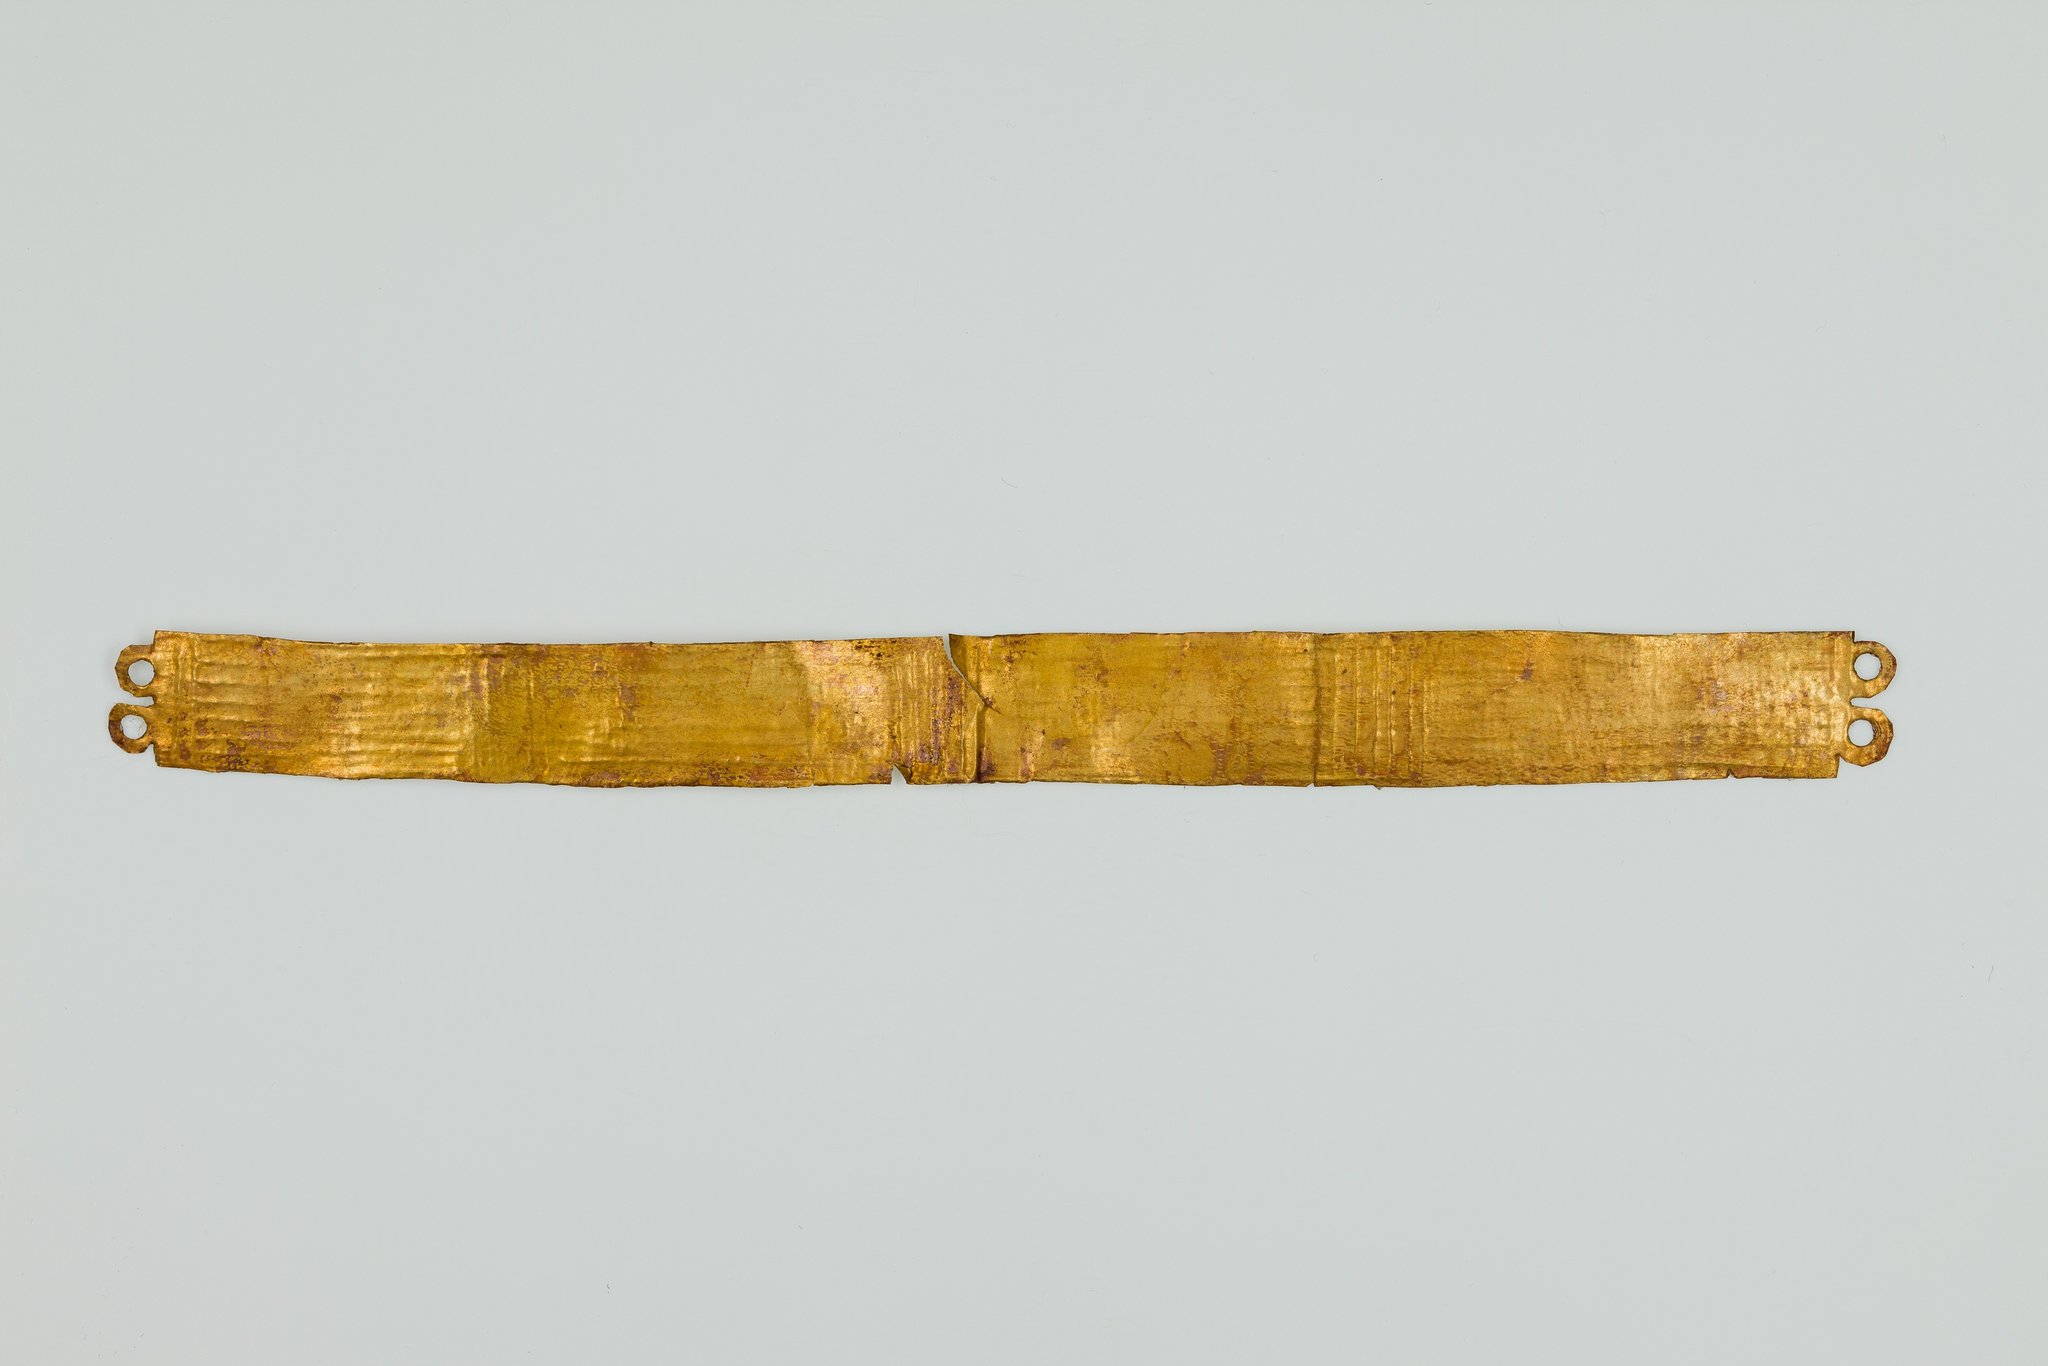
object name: amulet, sheet gold, bracelet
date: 664-380 BCE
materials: gold